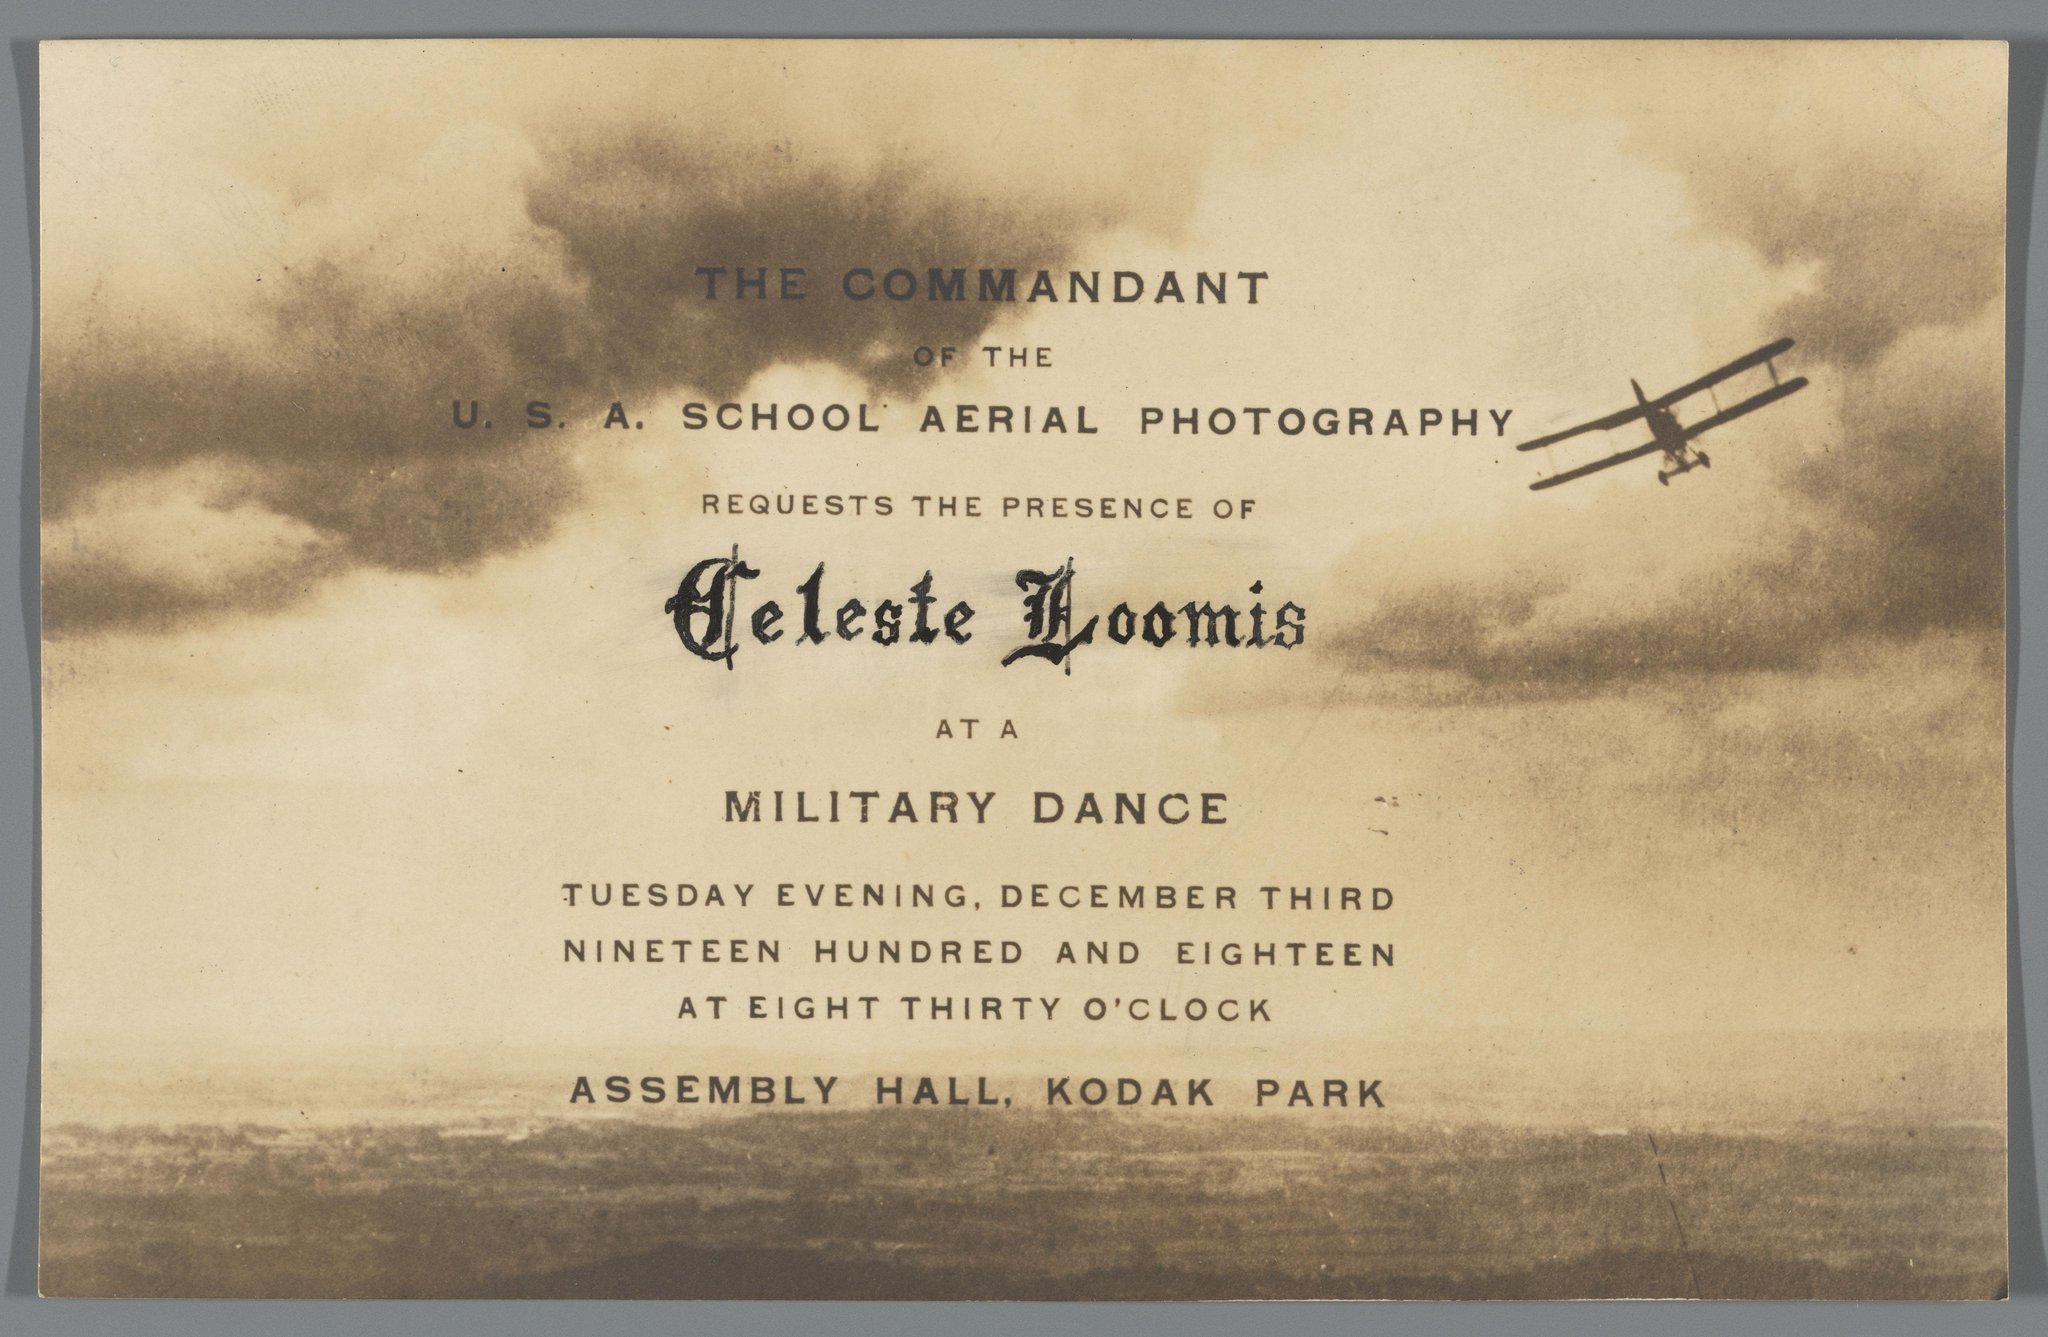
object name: photograph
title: Invitatie met foto van een vliegtuig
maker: Anonymous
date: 1918-1919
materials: photographic support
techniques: gelatin silver print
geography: united states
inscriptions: inscription: ‘THE COMMANDANT / OF THE / U.S.A. SCHOOL AERIAL PHOTOGRAPHY / REQUESTS THE PRESENCE OF / [in pen: Celeste Loomis] / AT A / MILITARY DANCE / TUESDAY EVENING, DECEMBER THIRD / NINETEEN HUNDRED AND EIGHTEEN / AT EIGHT THIRTY O’CLOCK / ASSEMBLY HALL, KODAK PARK ’